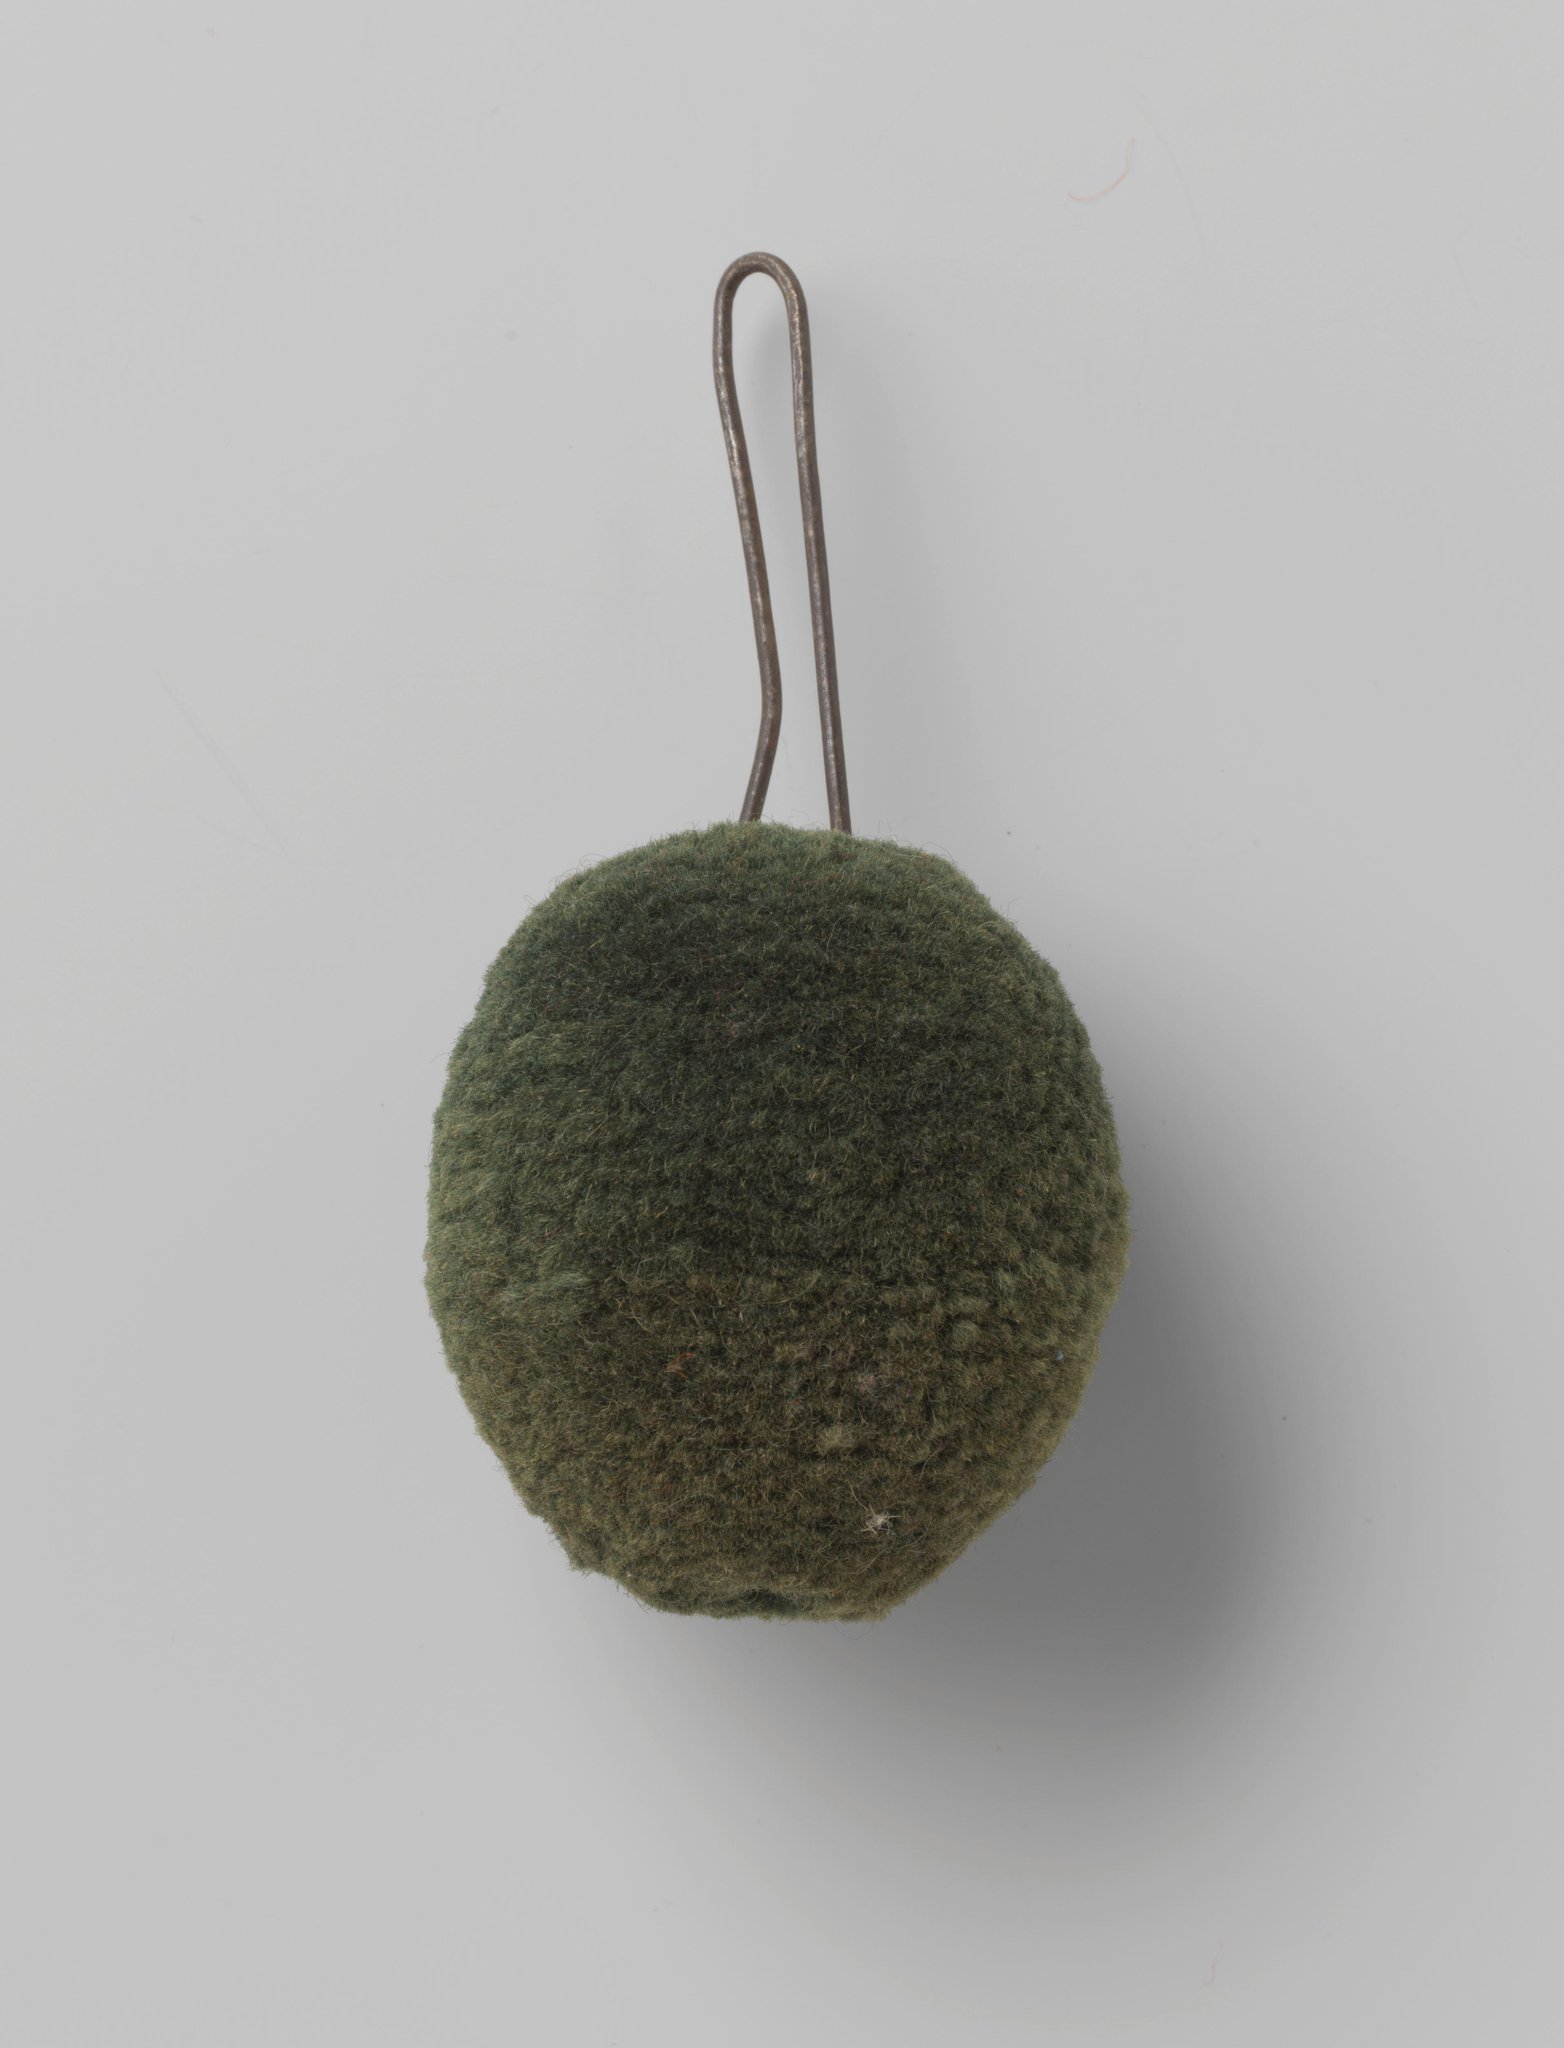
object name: bal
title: Bal voor sjako model 1828, van groene wol met wit ijzerdraad, voor alle rangen, bataljon of vrijwillige jagerkorpsen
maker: Anonymous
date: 1830-1831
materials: metal, wool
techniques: stitching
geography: netherlands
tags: netherlands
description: Bal voor sjako model 1828, van groene wol met wit ijzerdraad, waaraan etiket met tekst: Rijksmuseum, Amsterdam. Voor alle rangen, bataljon, of vrijwillige jagerkorpsen, ca. 1830-1831.